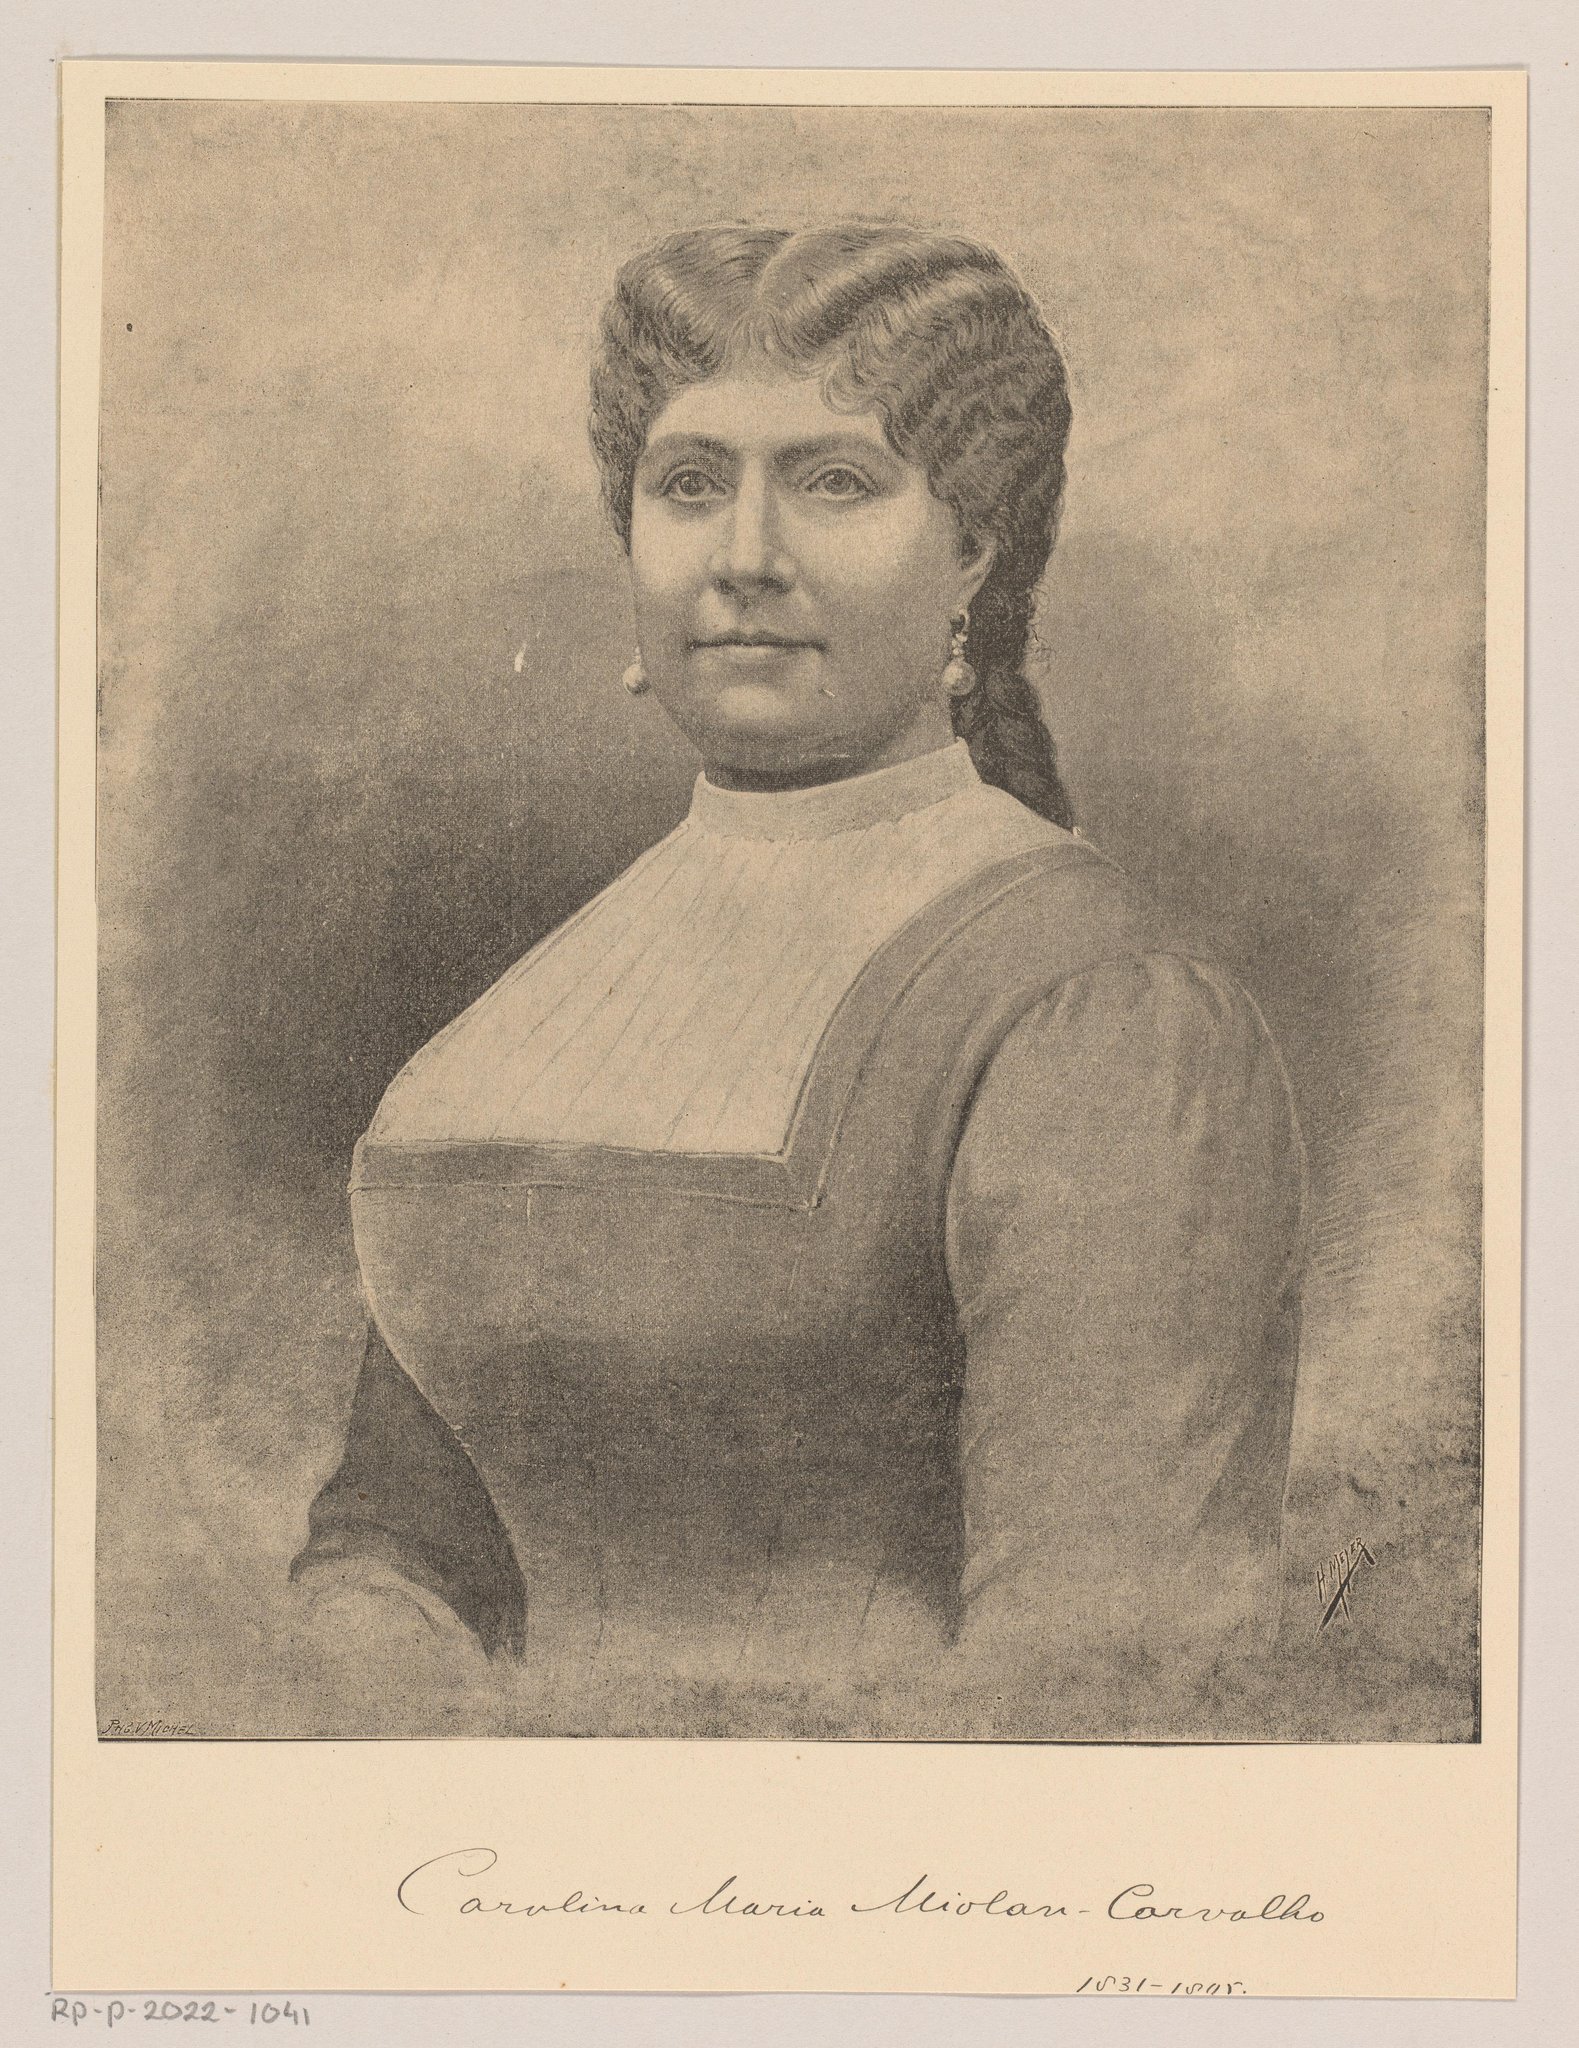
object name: photomechanical print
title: Portret van Marie Caroline Miolan-Carvalho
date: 1882-1970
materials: paper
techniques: snipping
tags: historical persons - bb - woman, opera-singer (female)